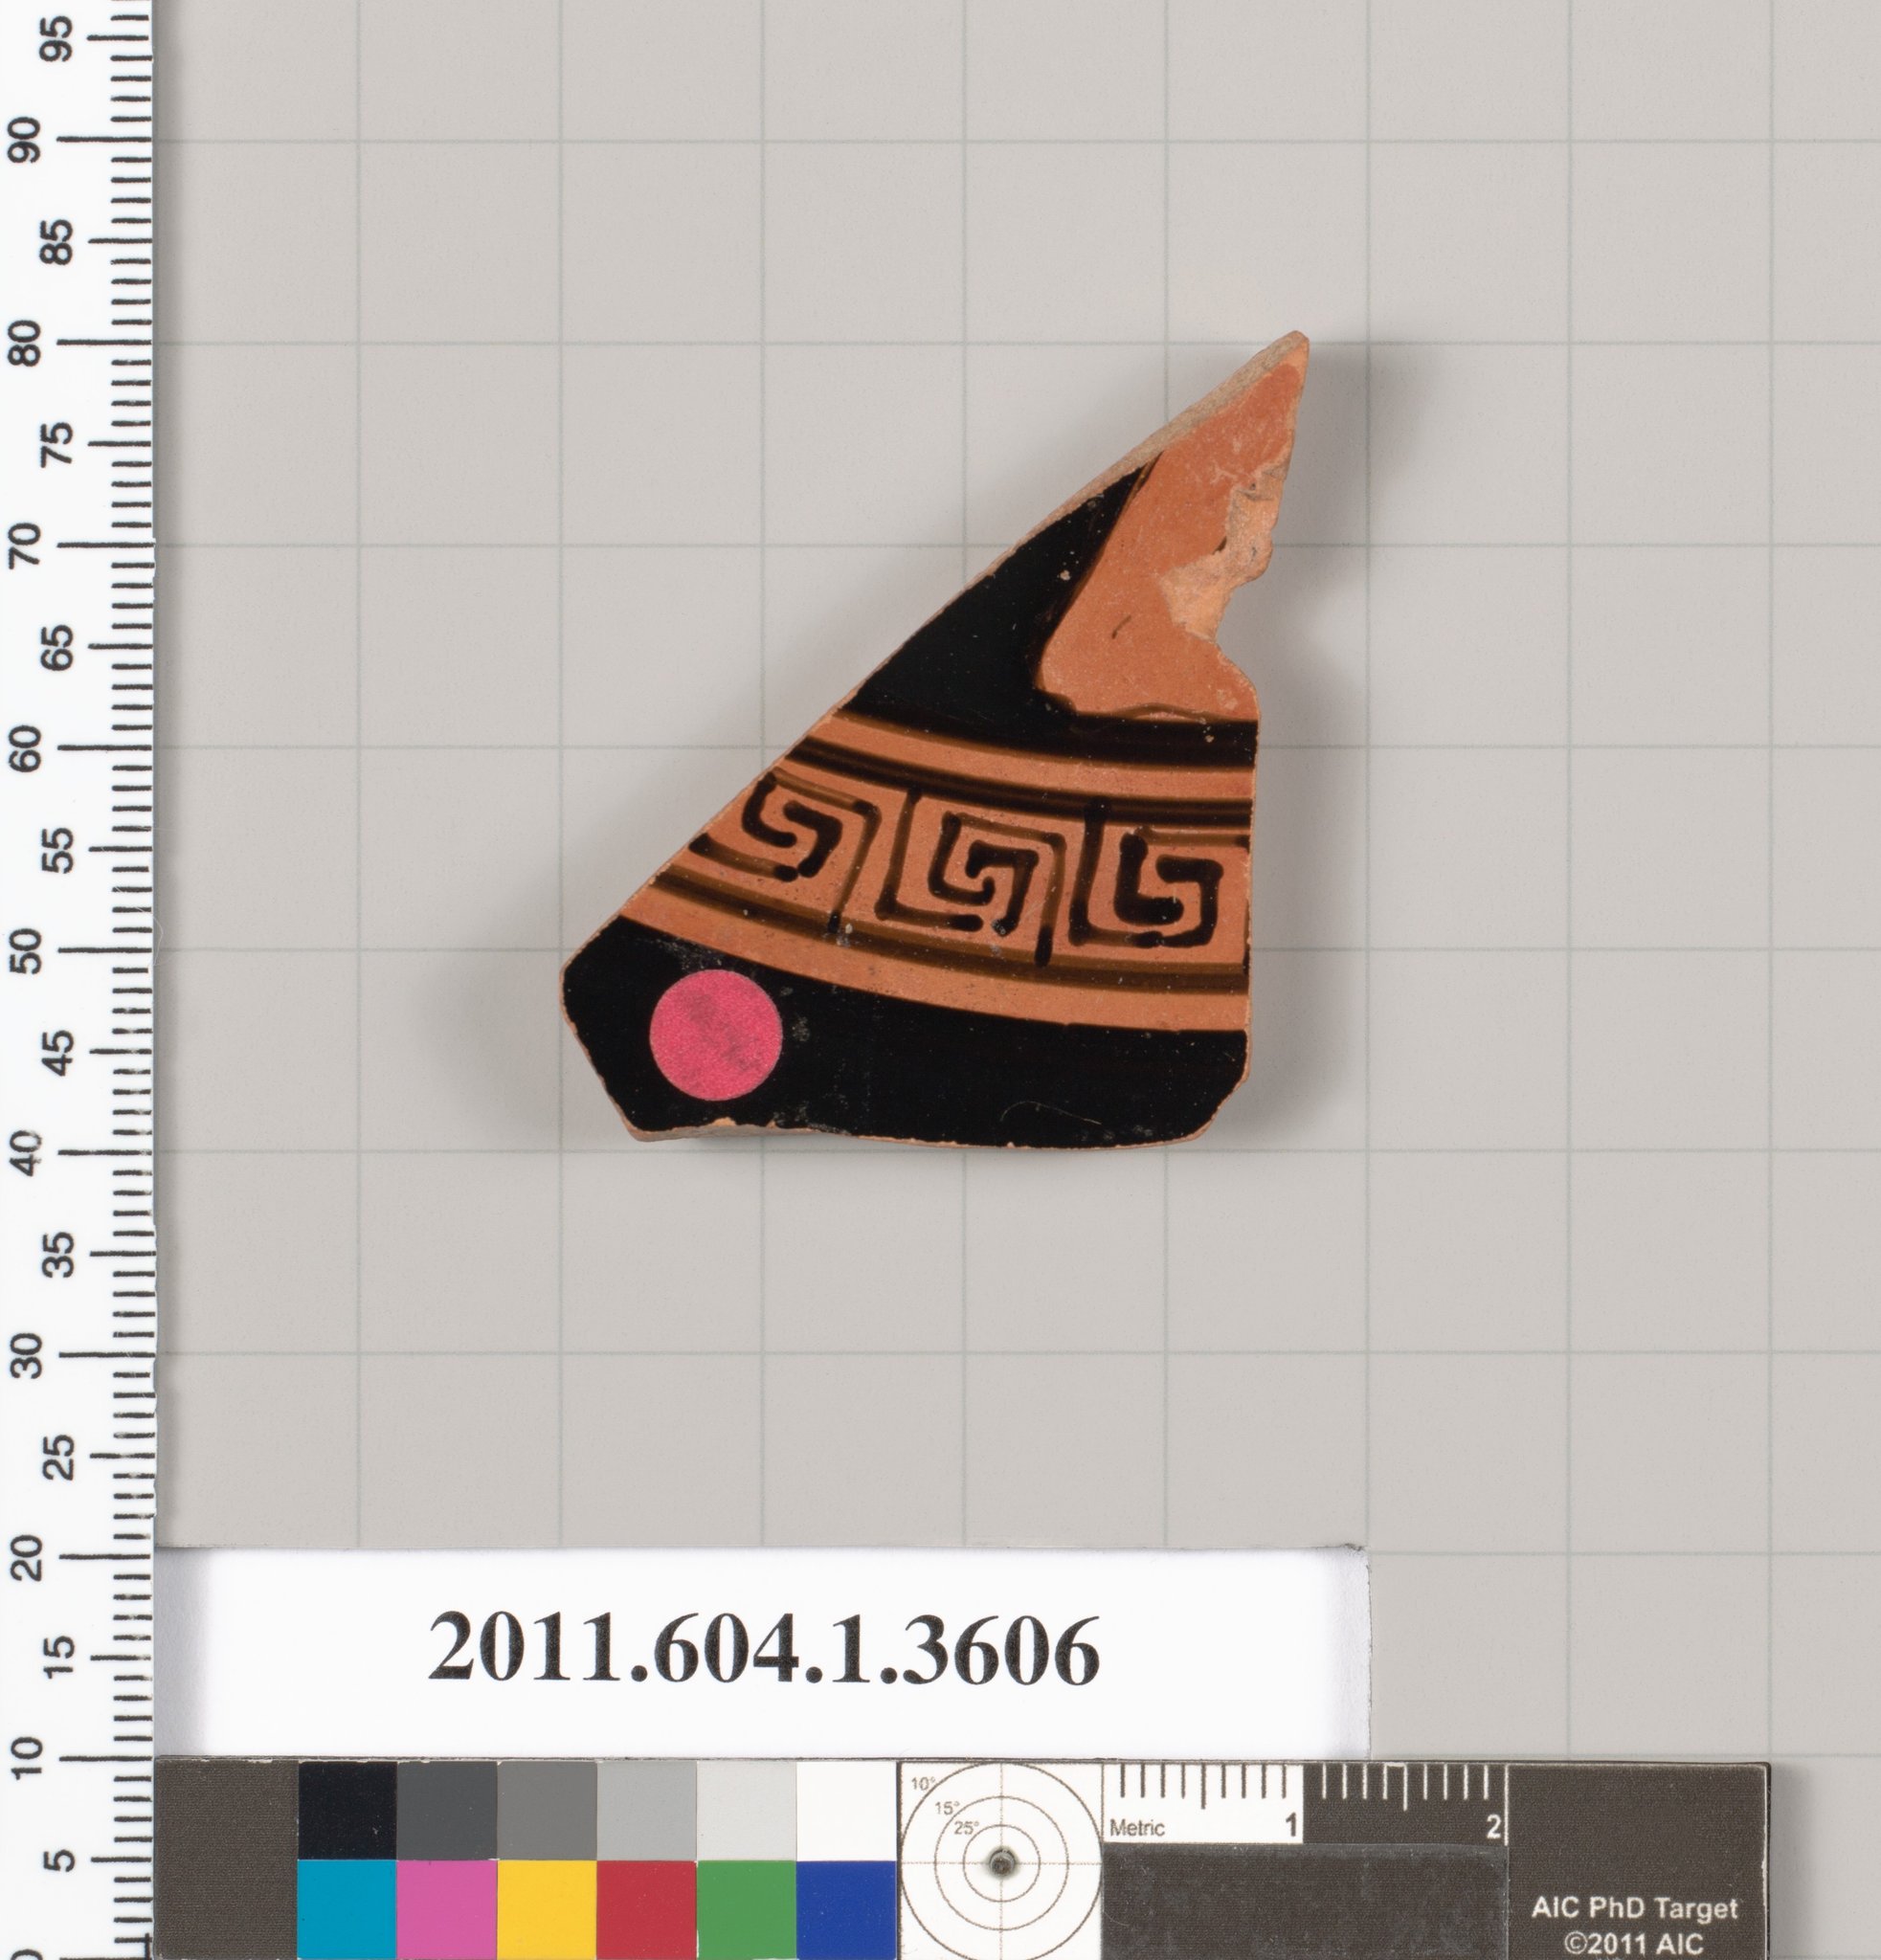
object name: kylix fragment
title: Terracotta fragment of a kylix (drinking cup)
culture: greek, attic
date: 500-480 BCE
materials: terracotta